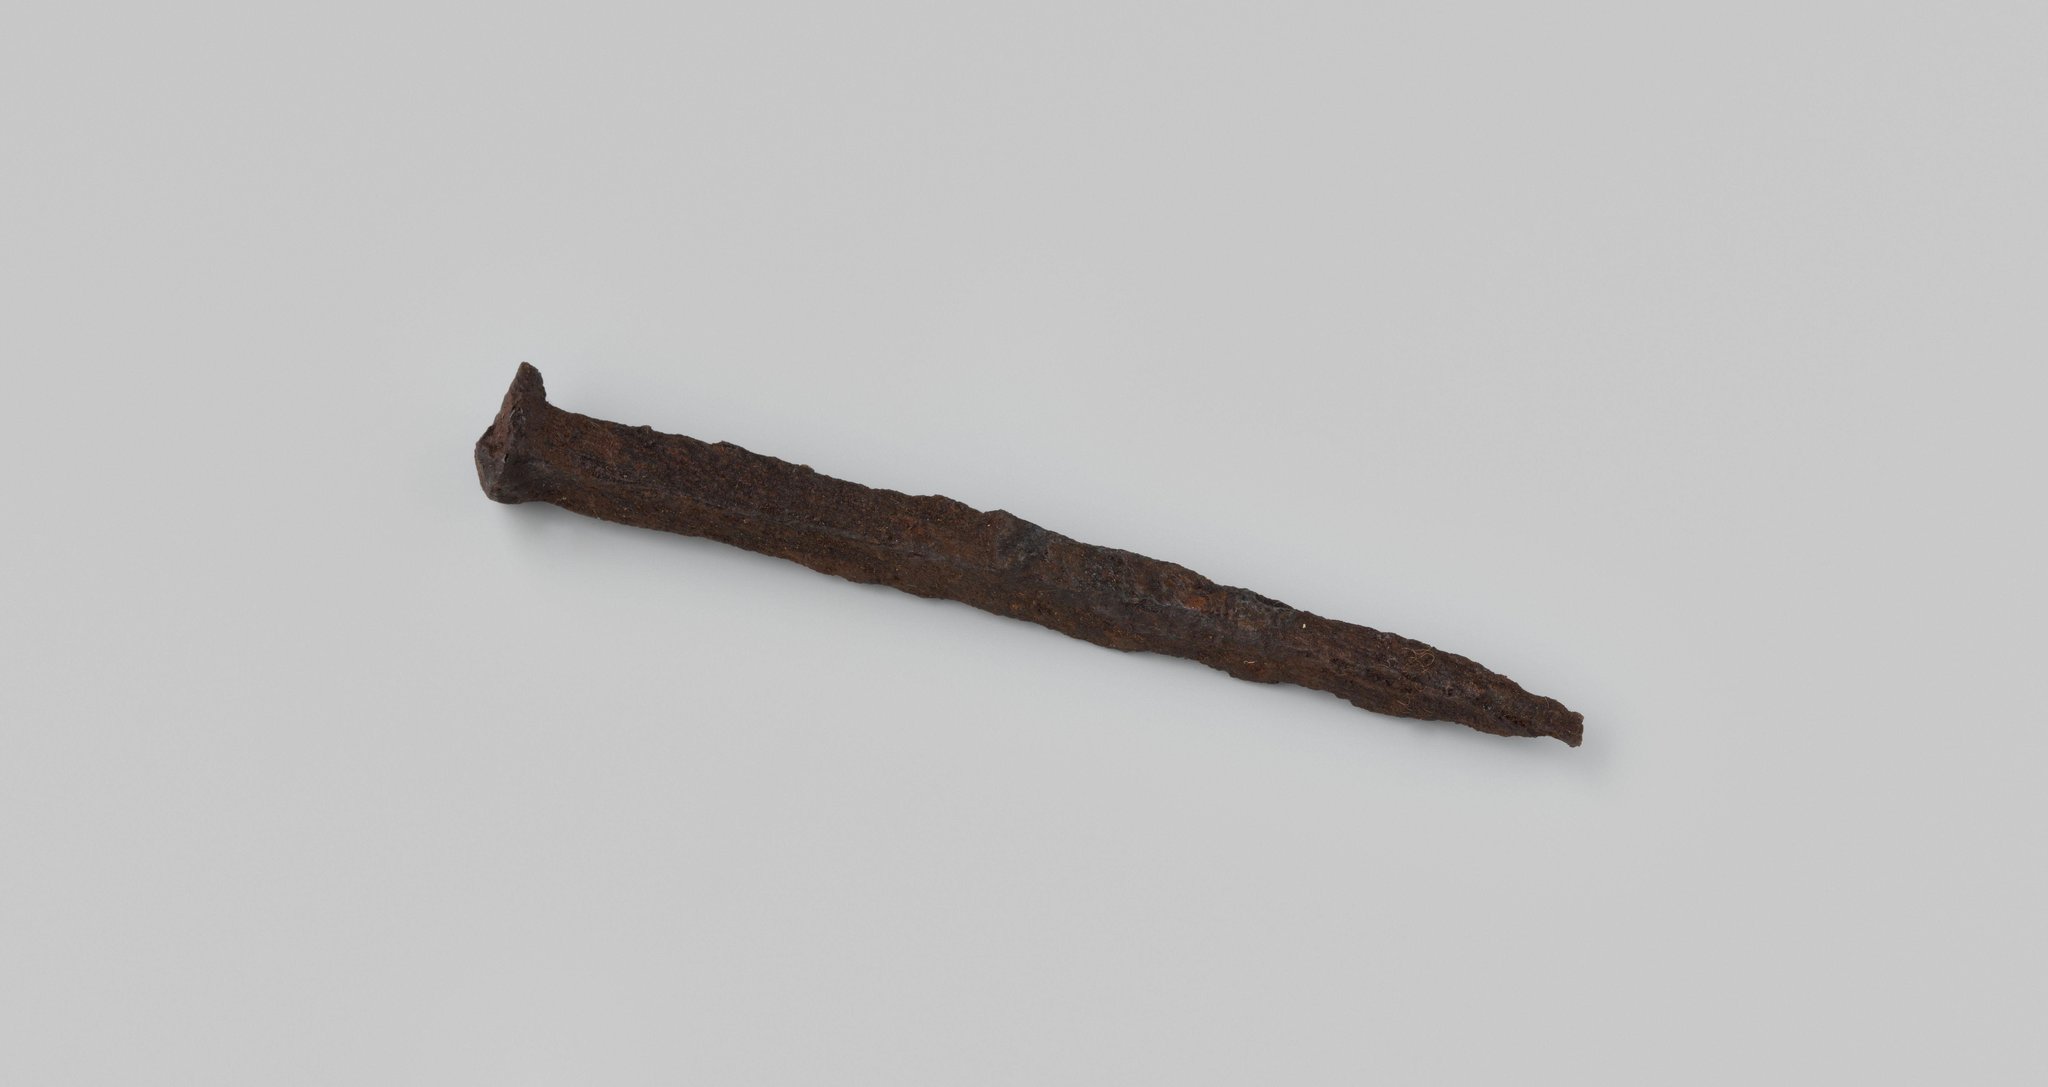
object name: nagel, spijker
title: Spijker afkomstig uit het wrak van de Oost-Indiëvaarder Hollandia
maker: Anonymous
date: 1700-1743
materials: iron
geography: netherlands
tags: verenigde oostindische compagnie, hollandia (schip)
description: Nails; rectangular, tapering pointed shaft, faceted head, eroded.